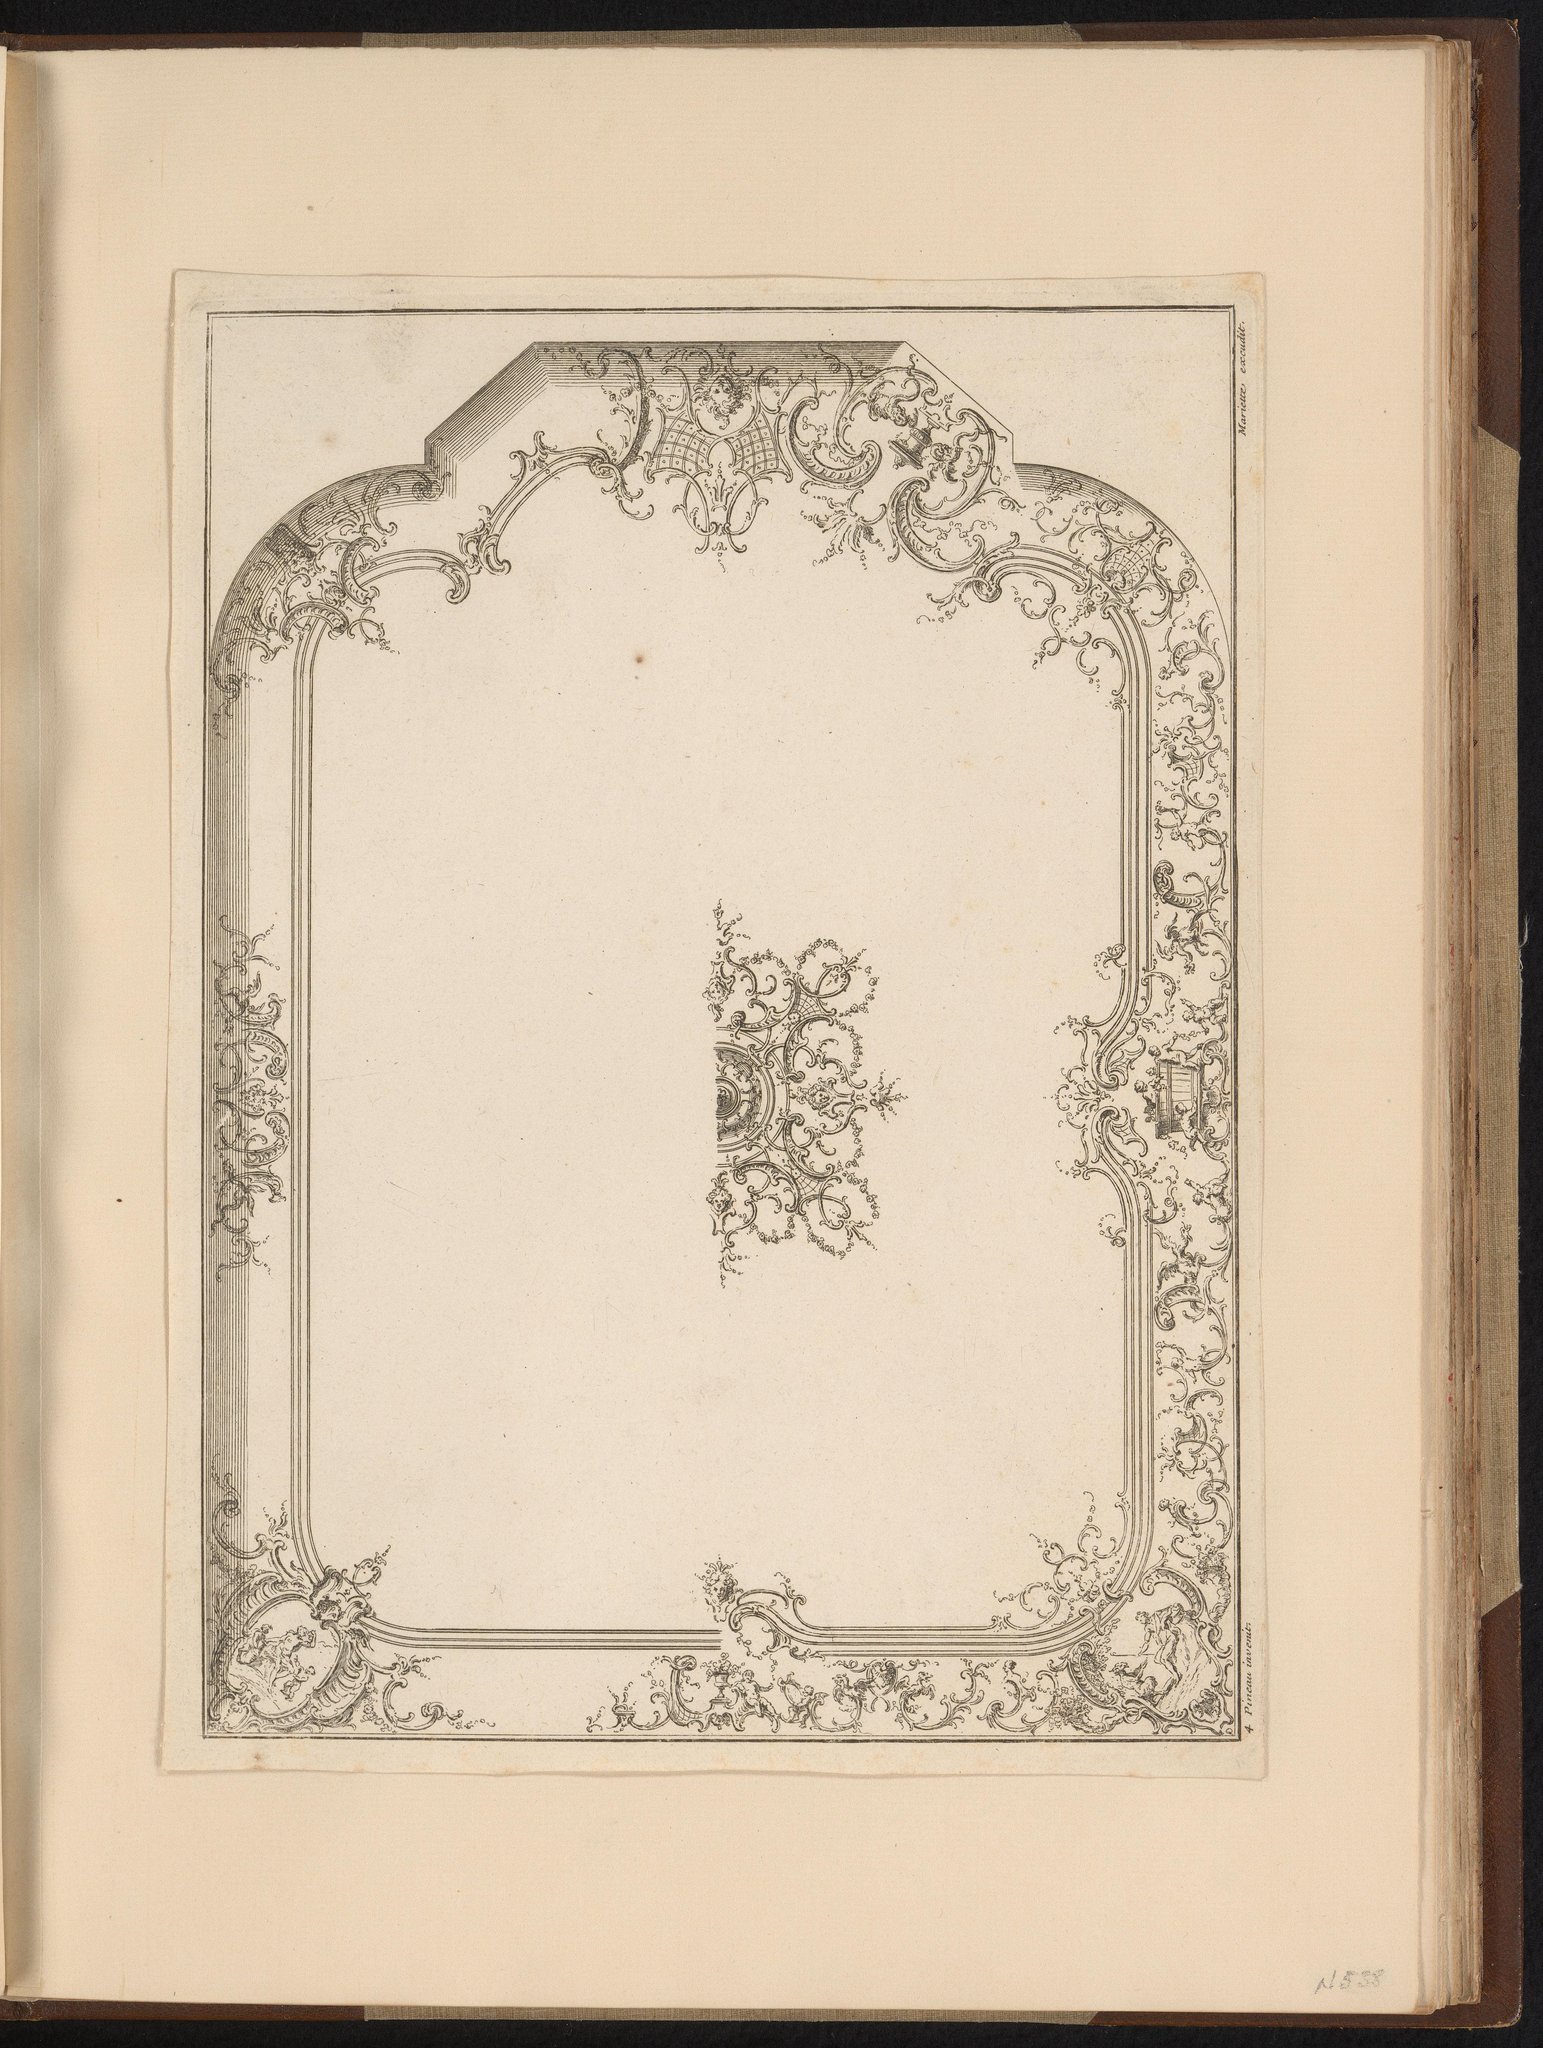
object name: album leaf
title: Ontwerp voor een plafond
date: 1725-1750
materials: paper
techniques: etching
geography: paris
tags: ornaments ~ art, (decorated) ceiling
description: De tweede prent uit deze reeks ontbreekt in dit album.